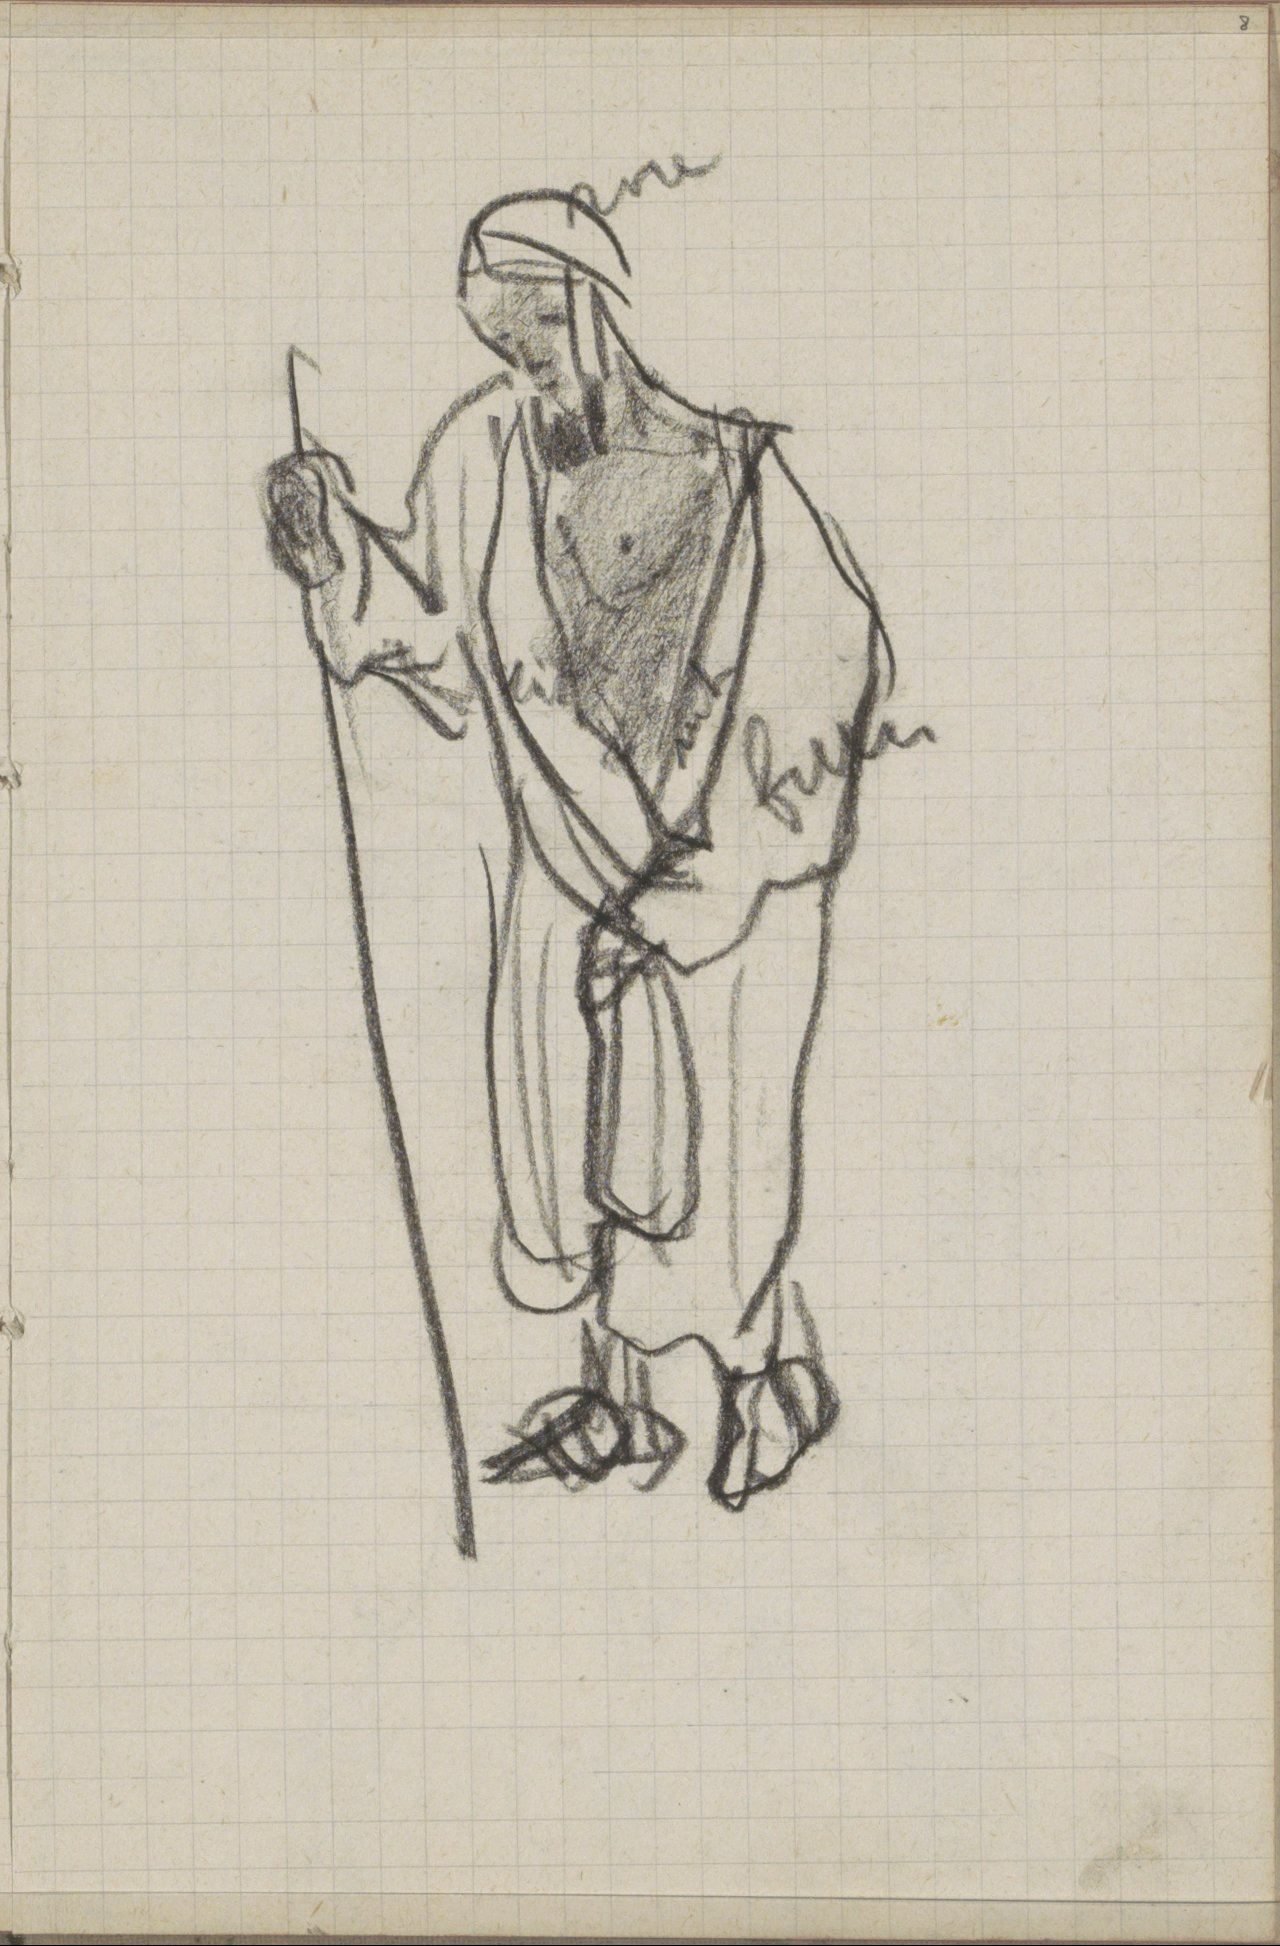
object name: sketchbook leaf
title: Man met staf in oosterse kleding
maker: marius bauer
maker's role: draughtsman, print maker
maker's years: 1867-1932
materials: chalk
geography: istanbul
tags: asiatic races and peoples, walking-stick, staff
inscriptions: kleurnotitie, handgeschreven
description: Vooraanzicht met hoofddeksel en half ontbloot bovenlijf. Pagina 8 uit een schetsboek met 51 bladen.